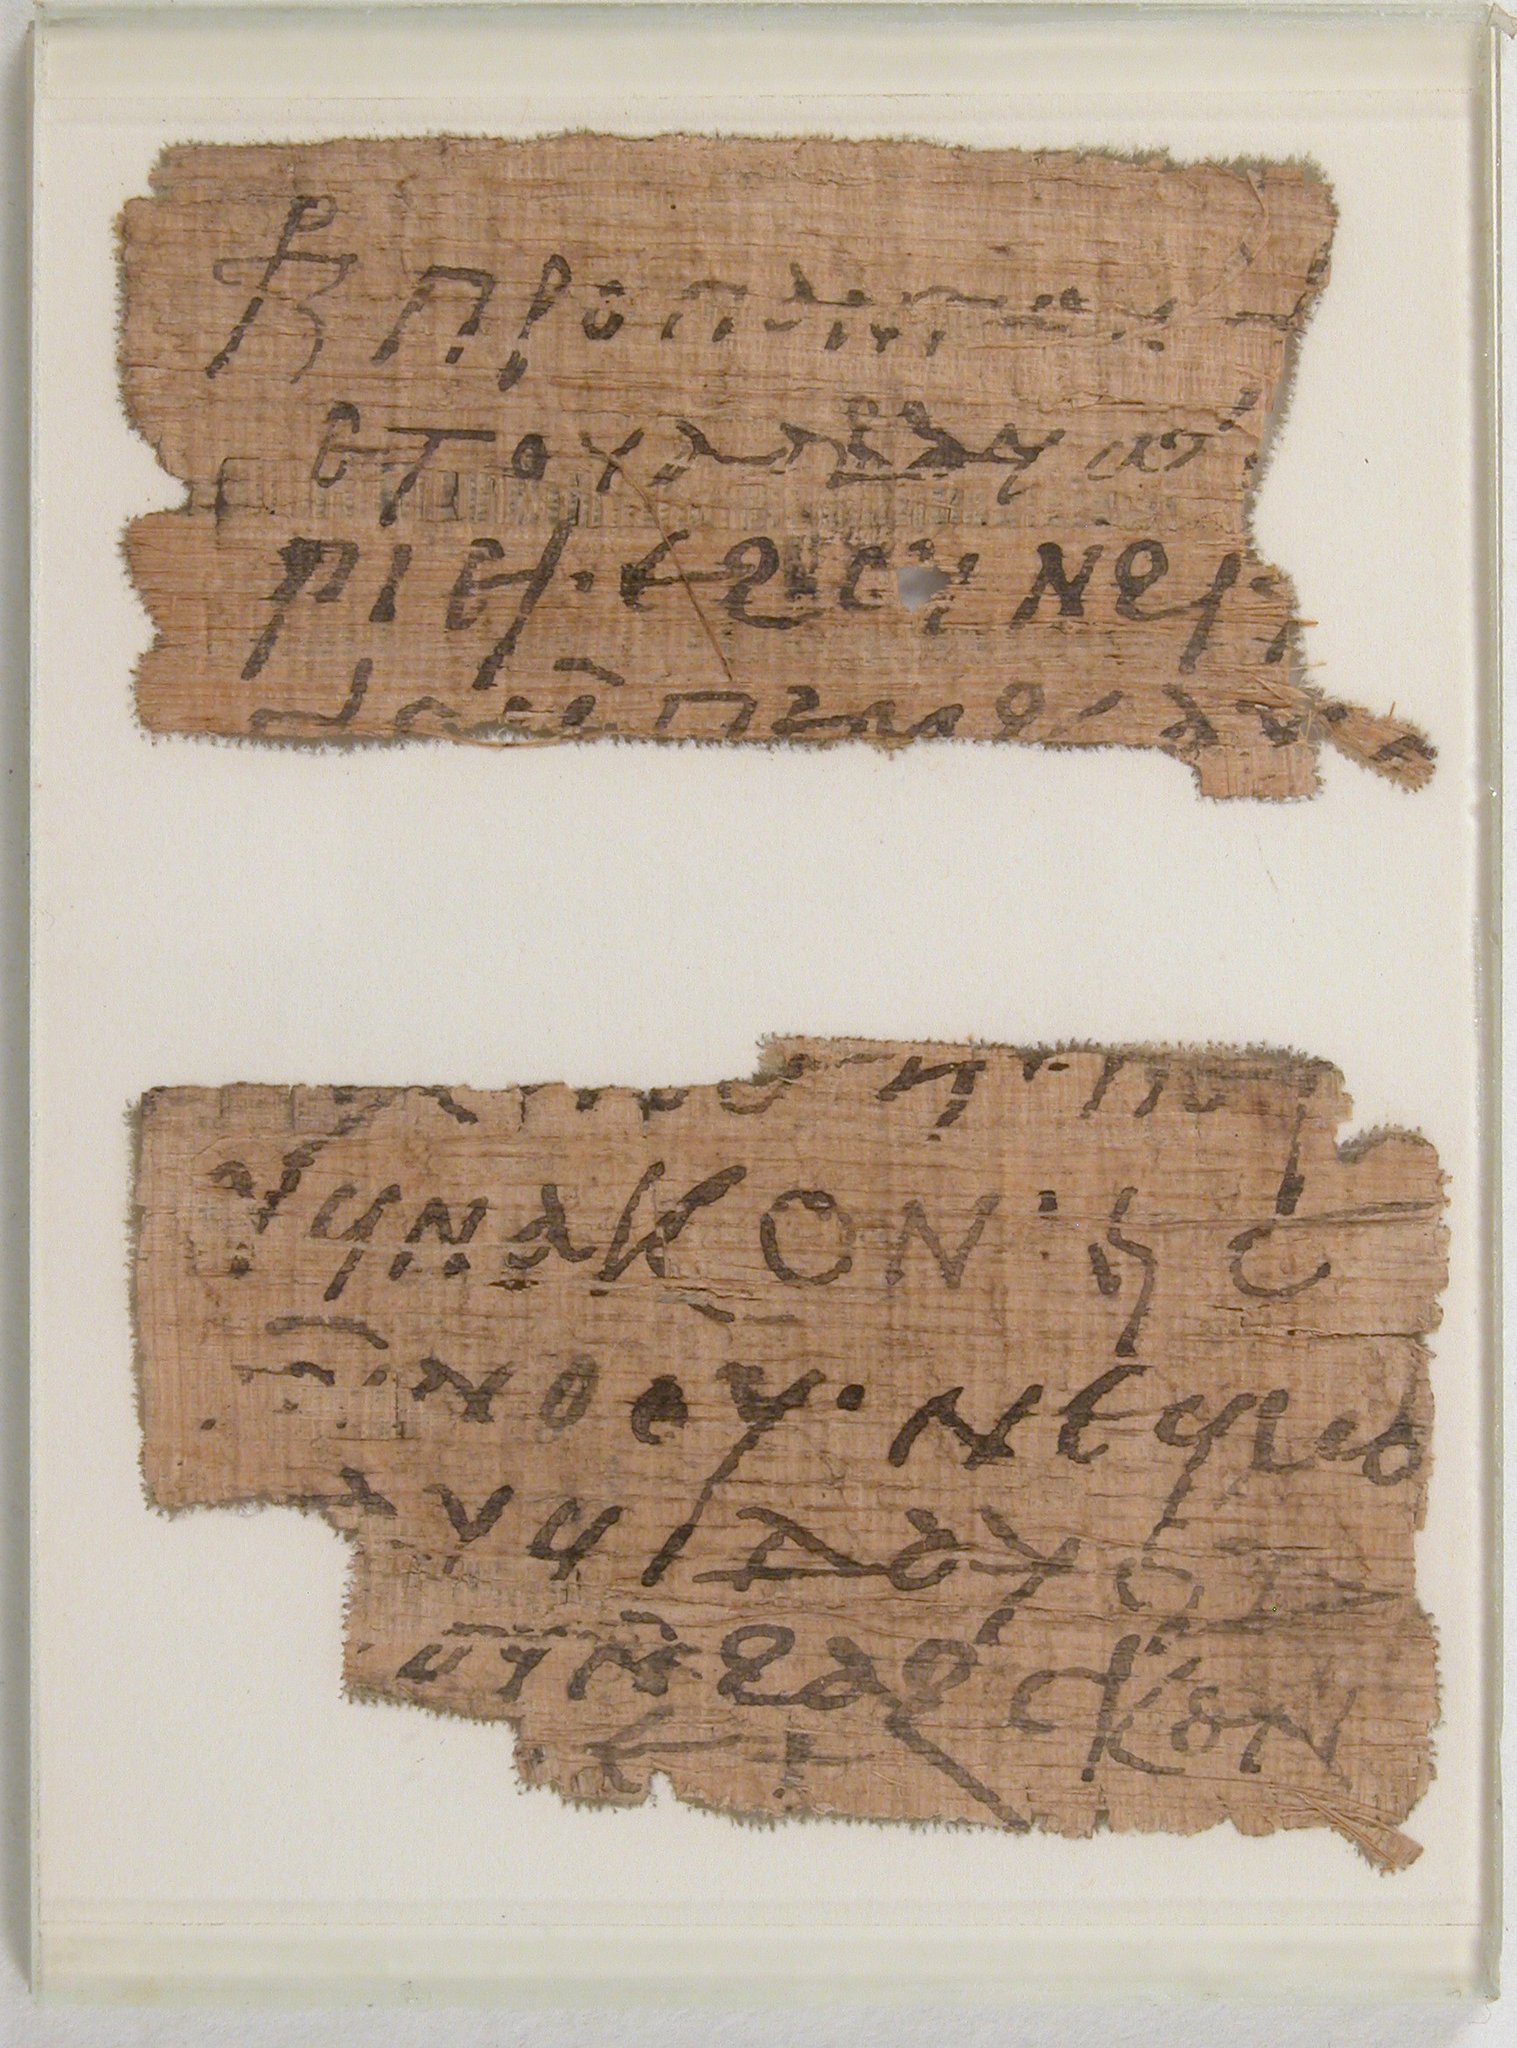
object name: fragment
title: Papyrus Fragments of a Letter from Cyriacus to Bishop Pesenthius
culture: coptic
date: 601-700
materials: ink, papyrus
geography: egypt